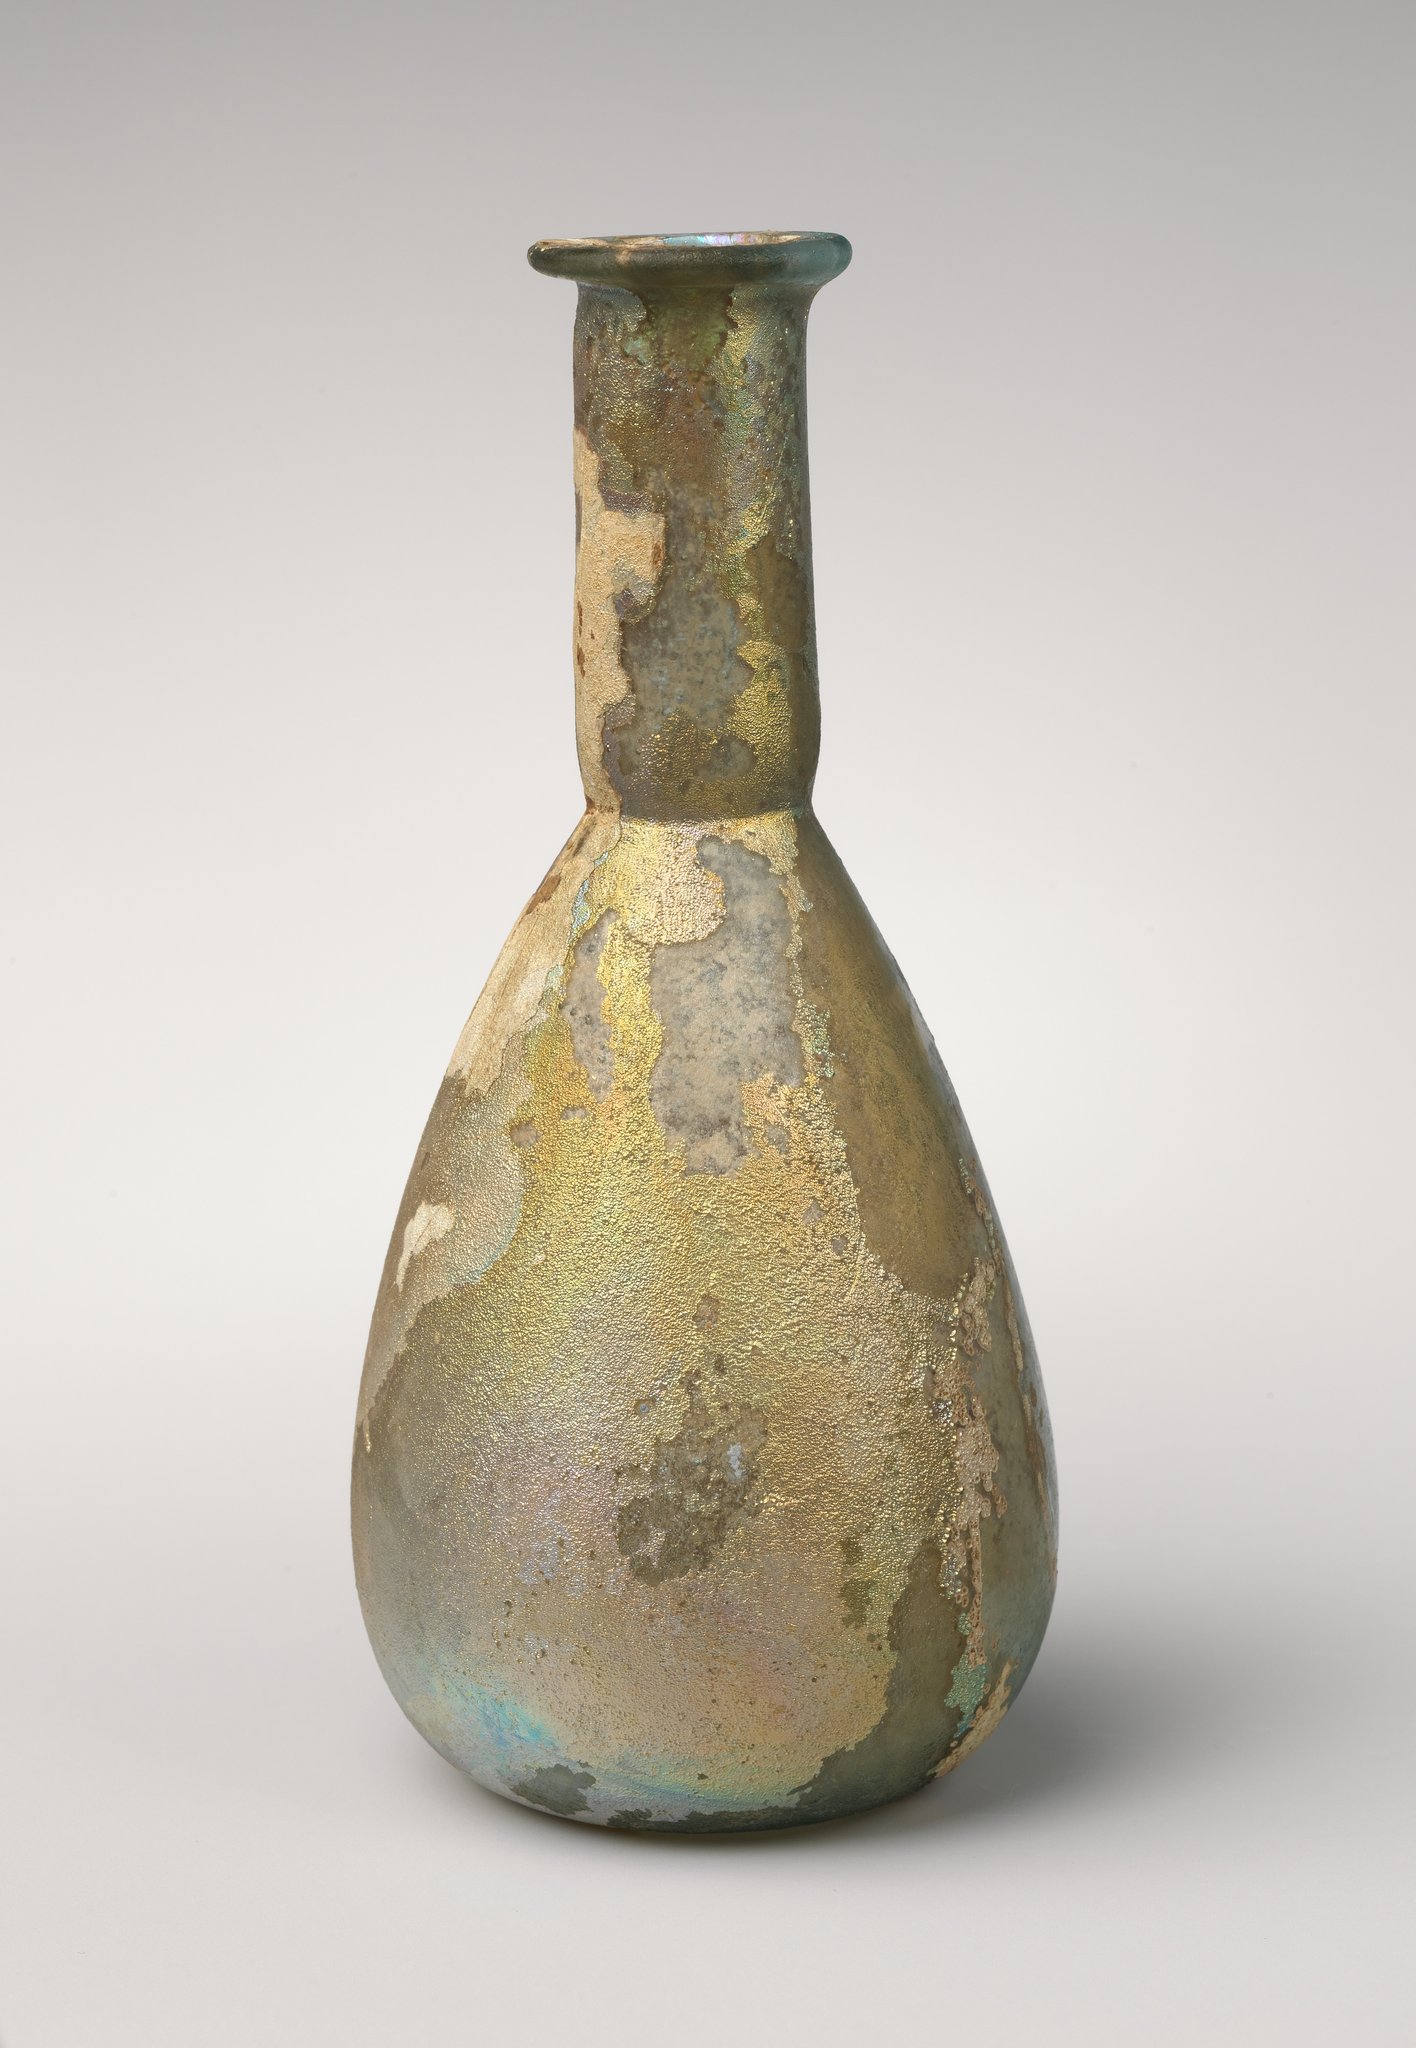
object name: perfume bottle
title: Glass perfume bottle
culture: roman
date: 1-100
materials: glass